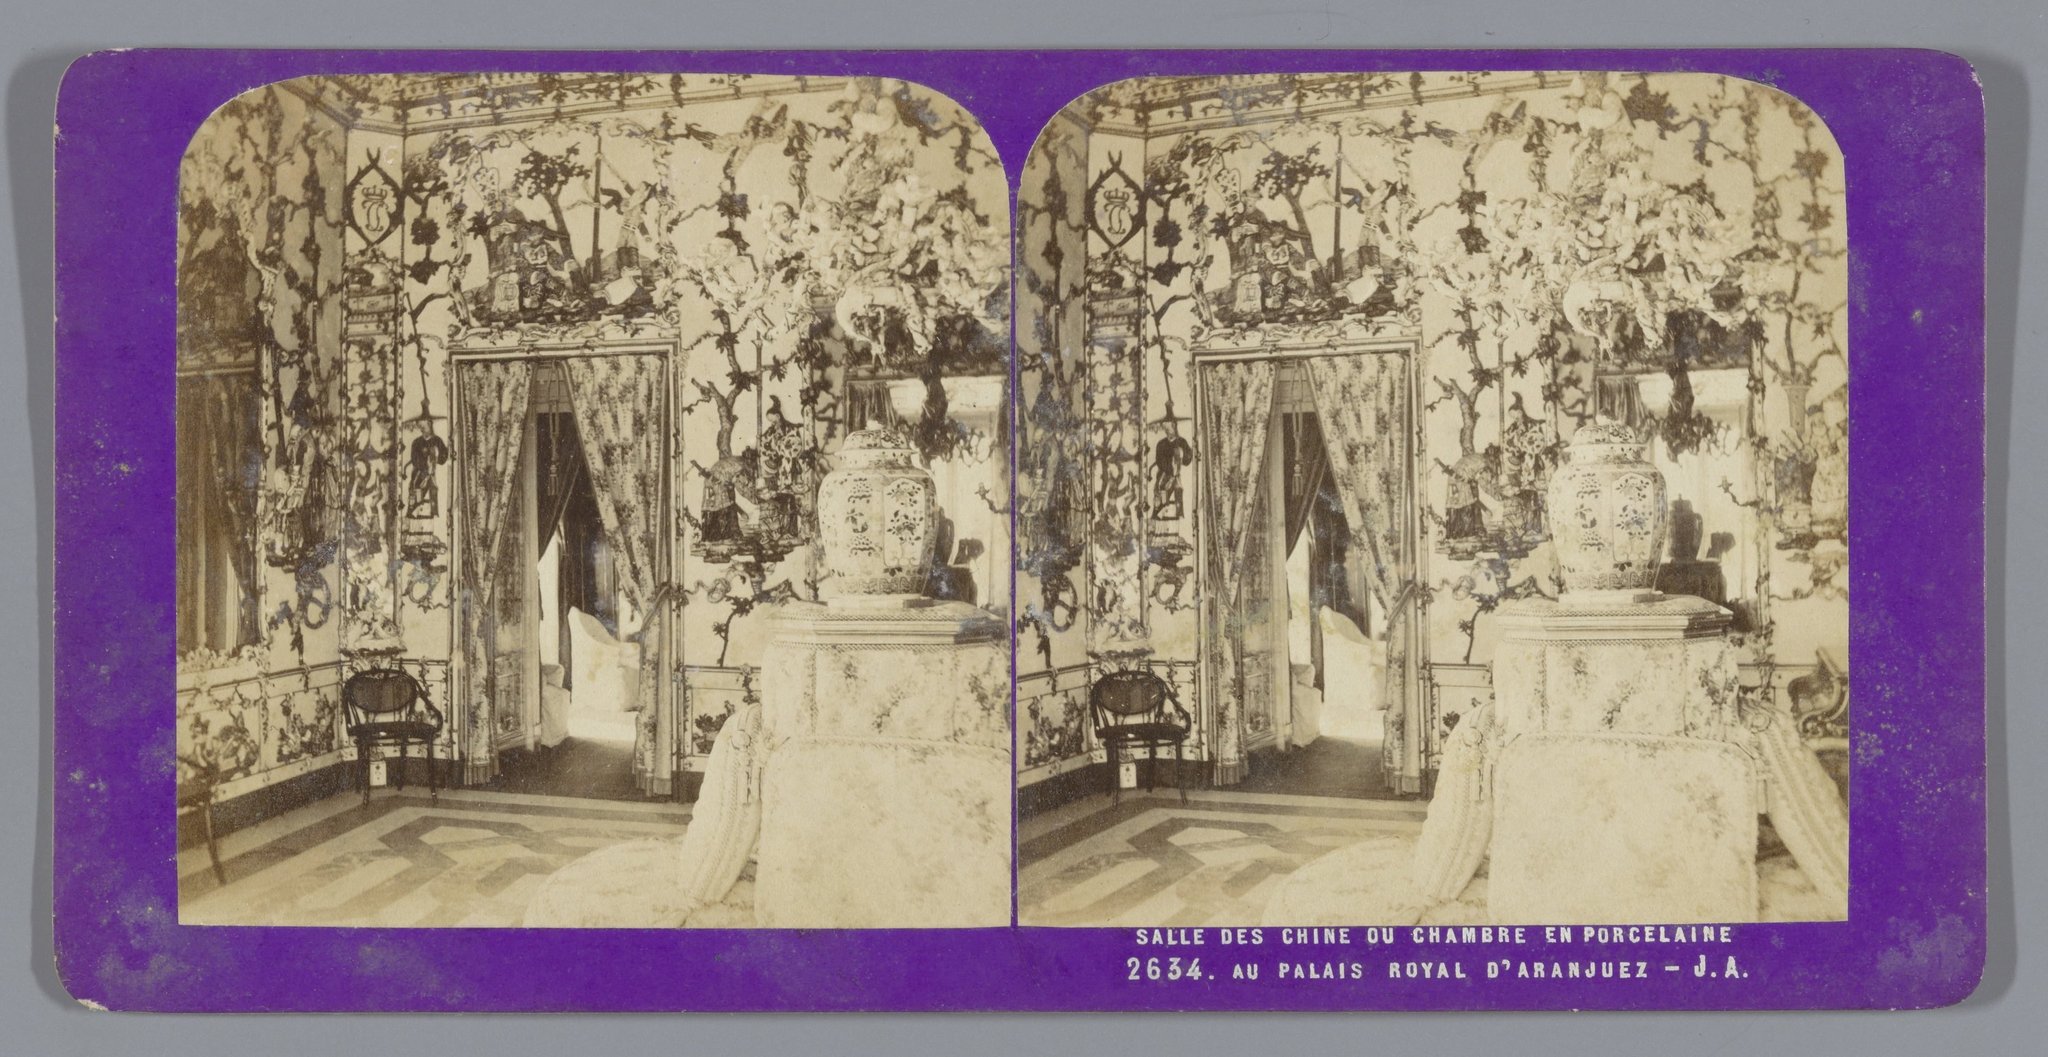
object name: stereograph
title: Porceleinkamer in het Koninklijk Paleis van Aranjuez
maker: jean andrieu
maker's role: fotograaf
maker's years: 1816-1872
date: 1862-1876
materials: cardboard, photographic support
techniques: albumen print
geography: royal palace of aranjuez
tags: palace, interior ~ representation of a building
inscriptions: number: ‘2634.’